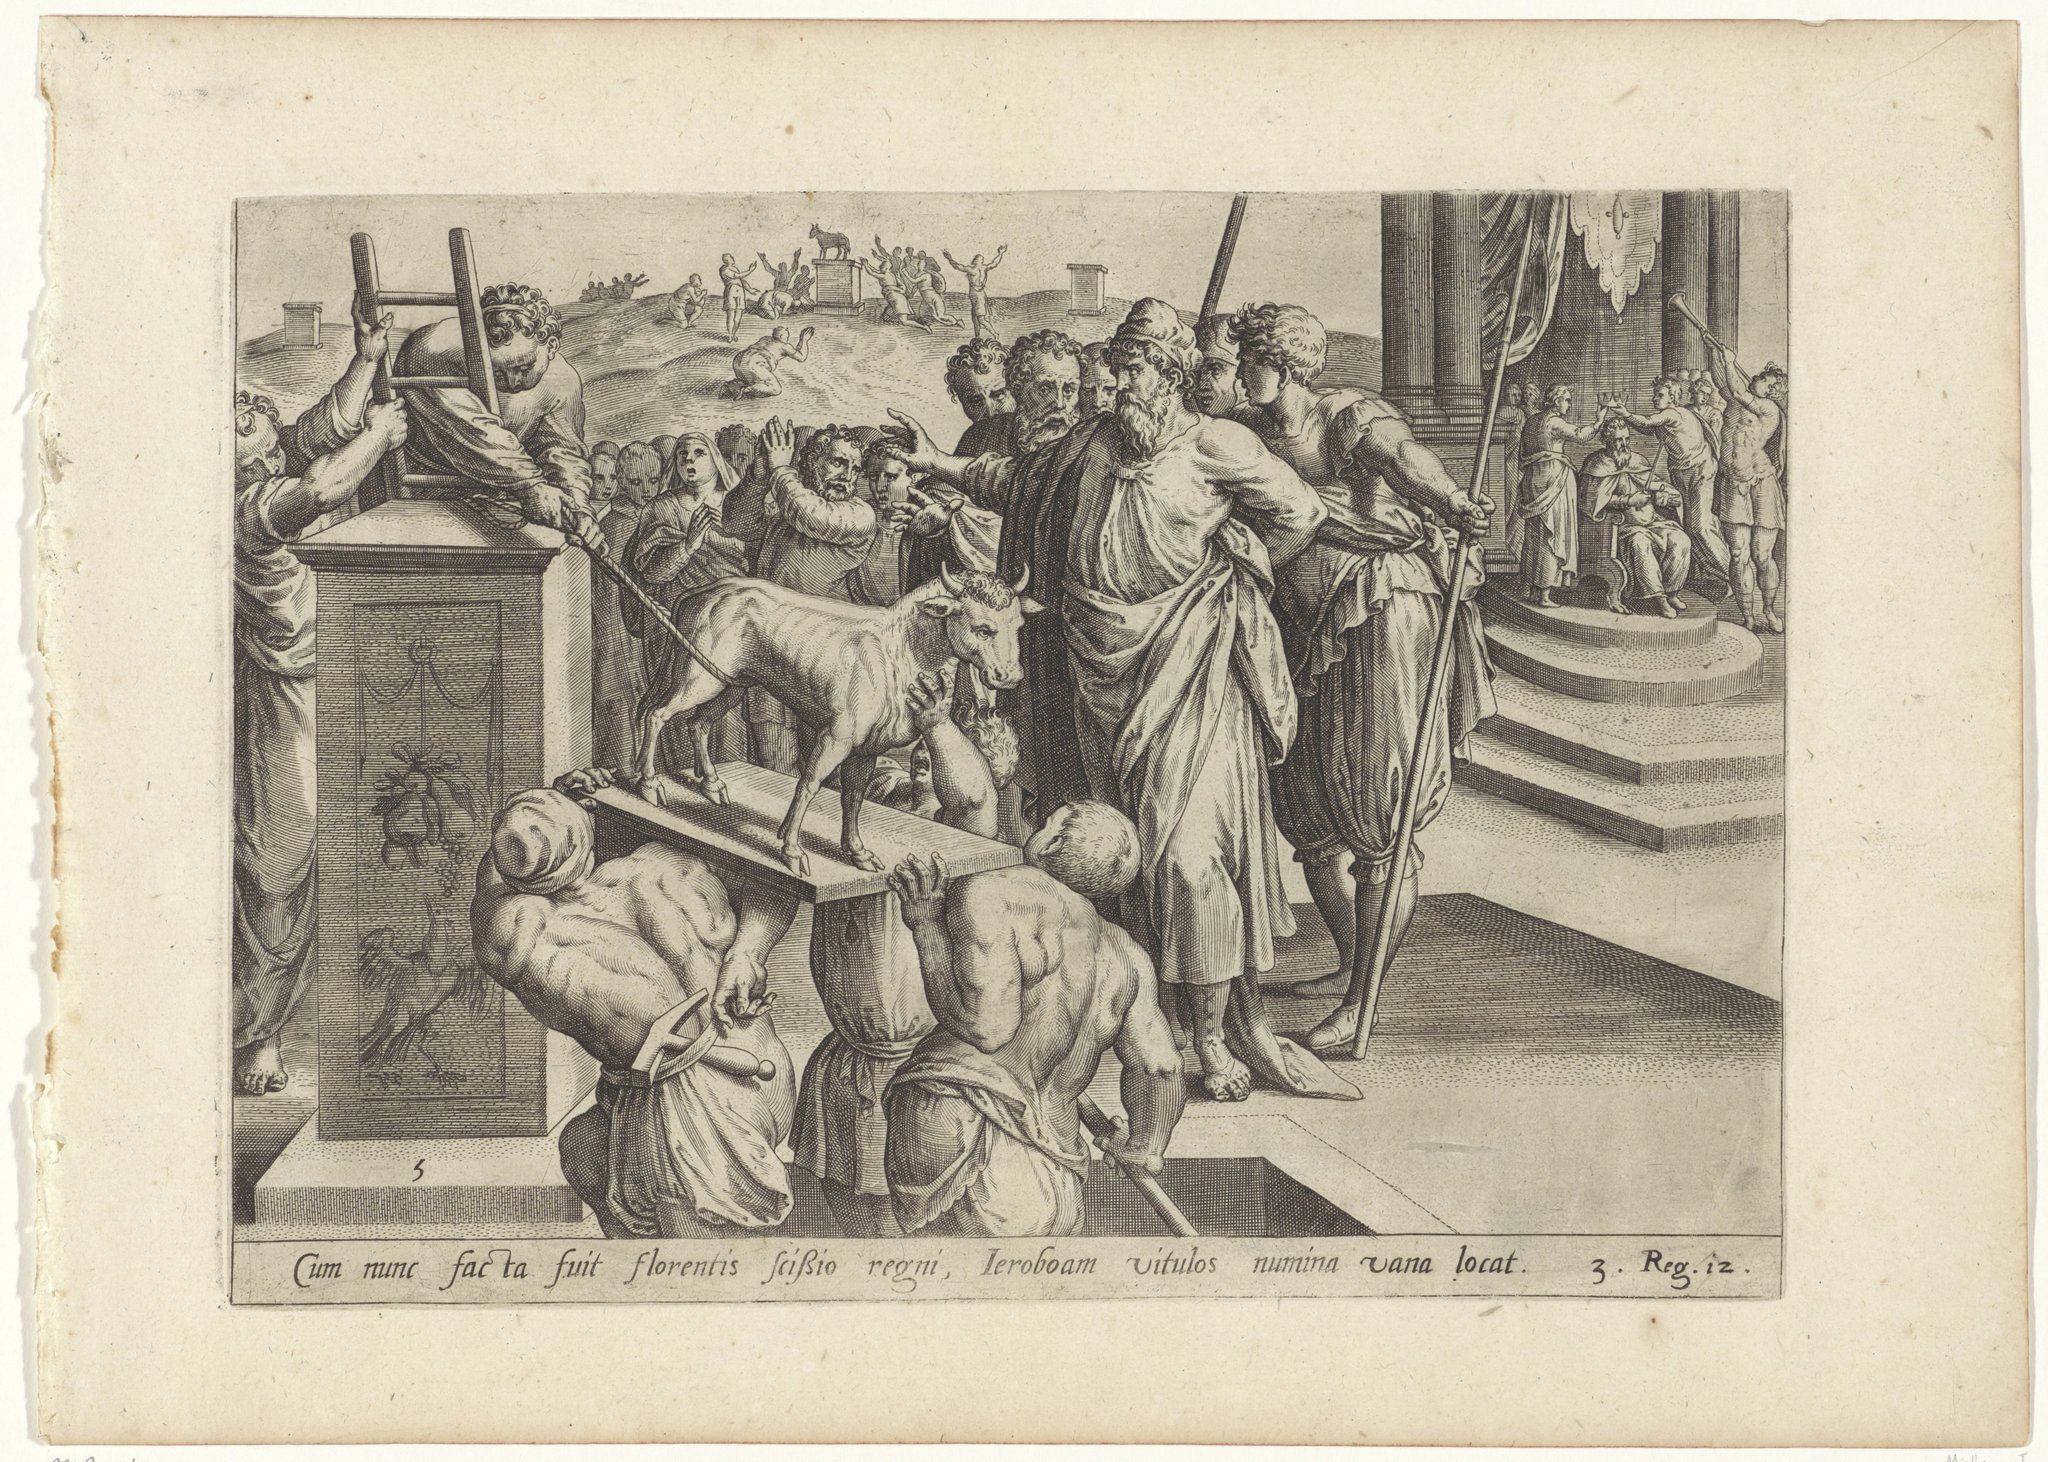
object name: print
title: Jerobeam laat twee gouden stierkalveren oprichten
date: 1579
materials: paper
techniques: engraving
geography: antwerp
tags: jeroboam sets up two golden calves, one in bethel and one in dan, the ten northern tribes make jeroboam king of israel and set up the capital of shechem (later exchanged for tirzah)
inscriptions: collector's mark: Lugt 2228, collector's mark: Lugt 2760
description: Prent gebruikt in: Thesaurus sacrarum historiaru veteris testamenti, elegatissimis imaginibus expressu excelletissimoru in hac arte viroru opera : nuc primu in luce editus. Antwerpen: Gerard de Jode, 1579. Of prent gebruikt in: Thesaurus sacrarum historiaru[m] veteris (et novi) testame[n]ti, elega[n]tissimis imaginibus expressu[m] excelle[n]tissimoru[m] in hac arte viroru[m] opera : nu[n]c primu[m] in luce[m] editus. Antwerpen: Gerard de Jode, 1585.